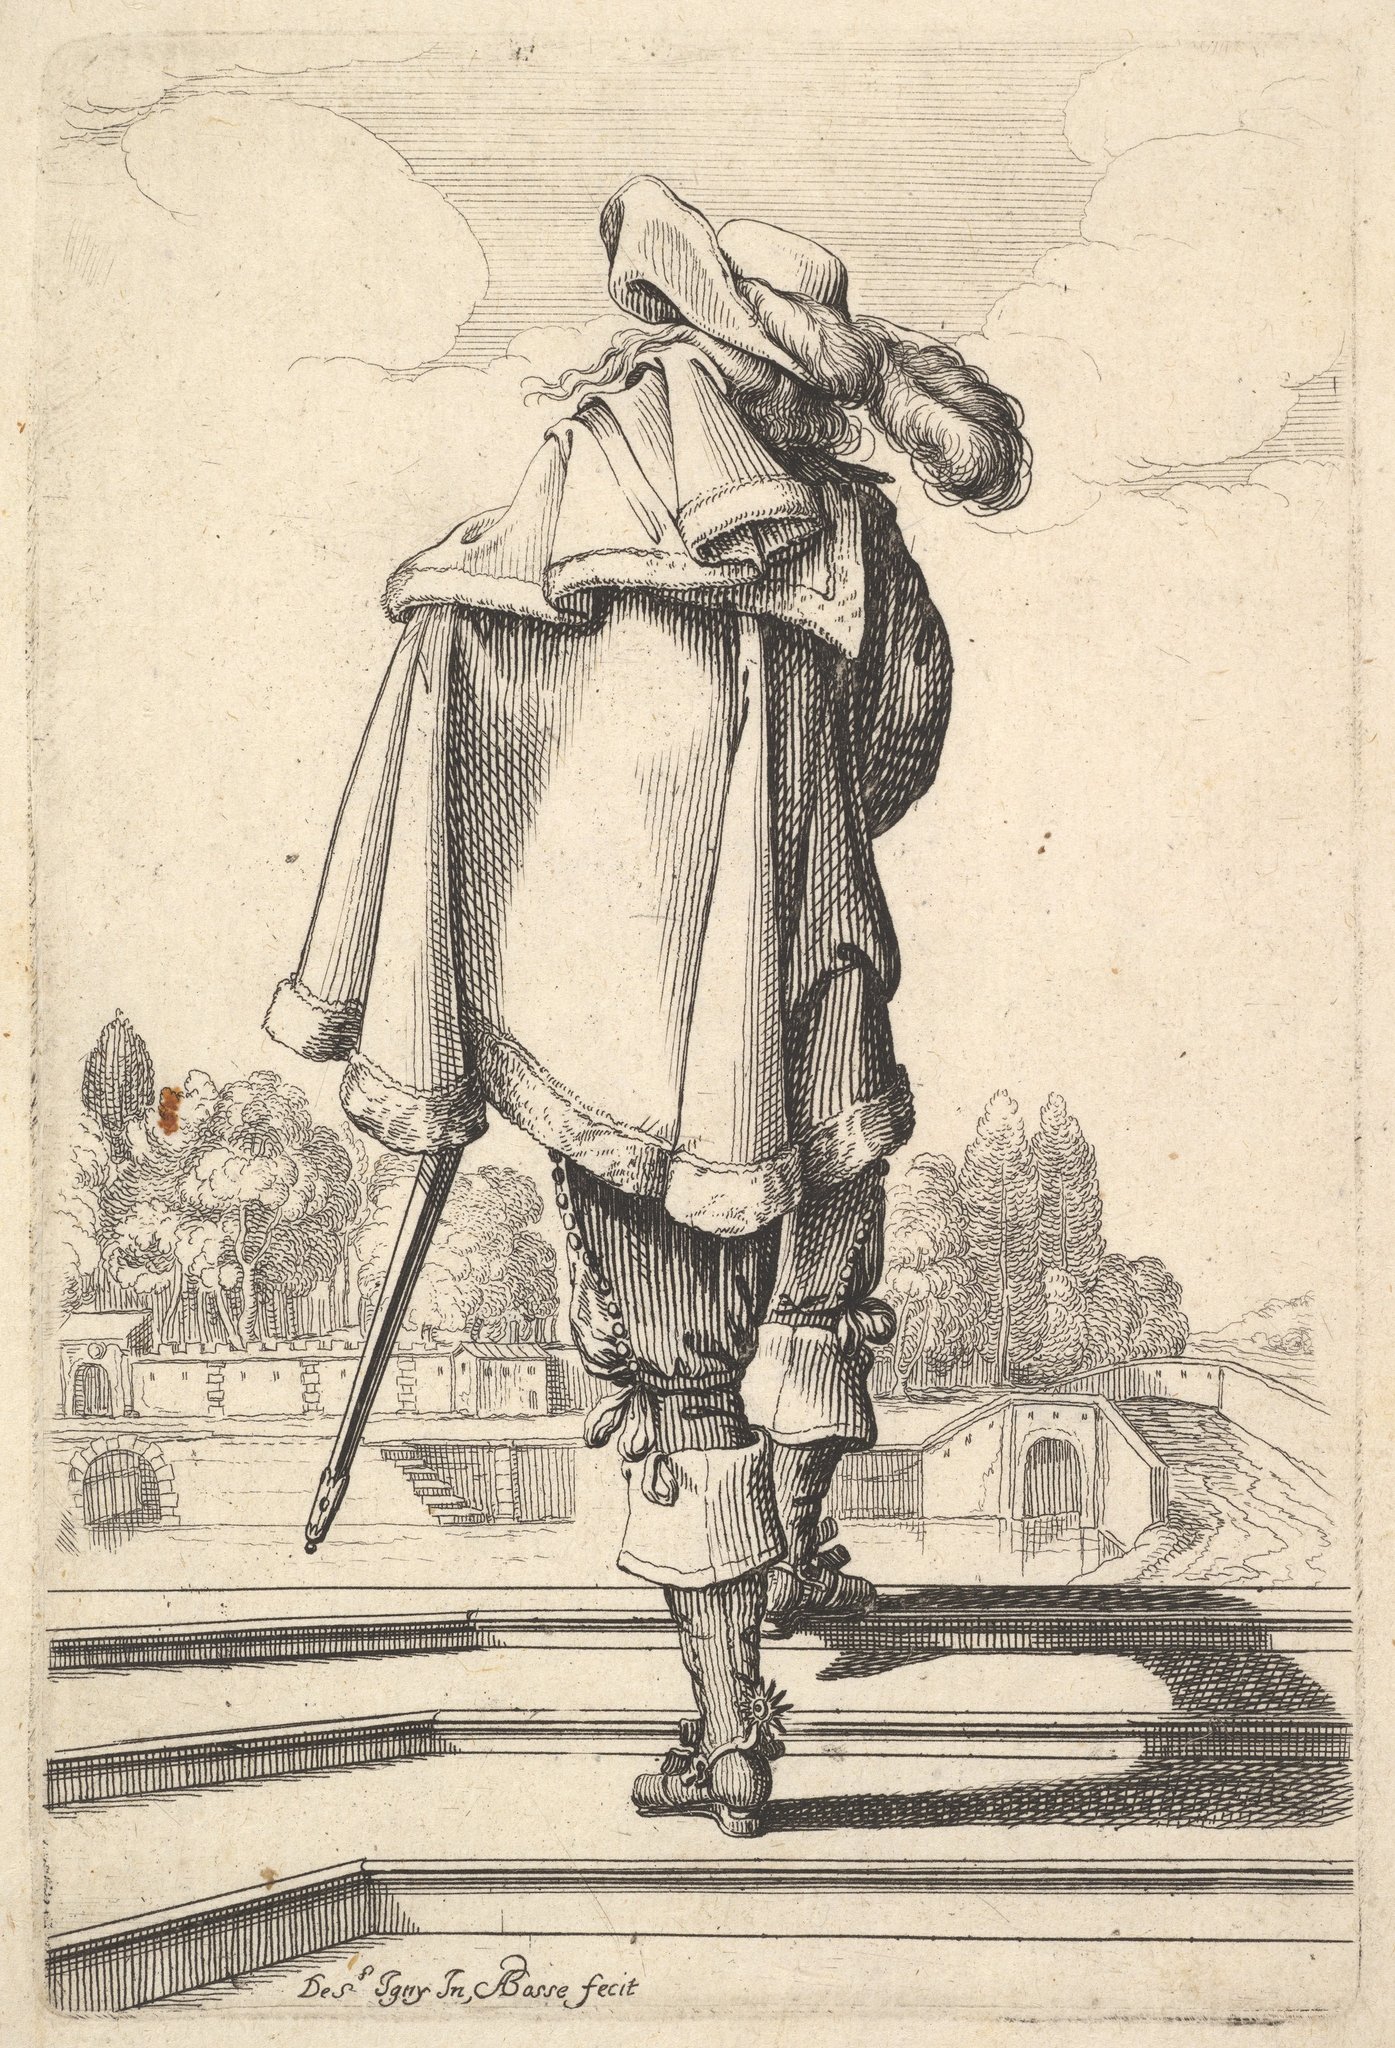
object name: print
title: A gentleman, seen from behind, walking up a parapet, with a cloak over his left shoulder, wearing a plumed hat and boots with spurs, from "The Garden of the French Nobles In Which One Can Pick Up Their Way of Dressing"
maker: abraham bosse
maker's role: artist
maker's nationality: french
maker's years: 1602-1676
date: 1629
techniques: etching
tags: men,walking